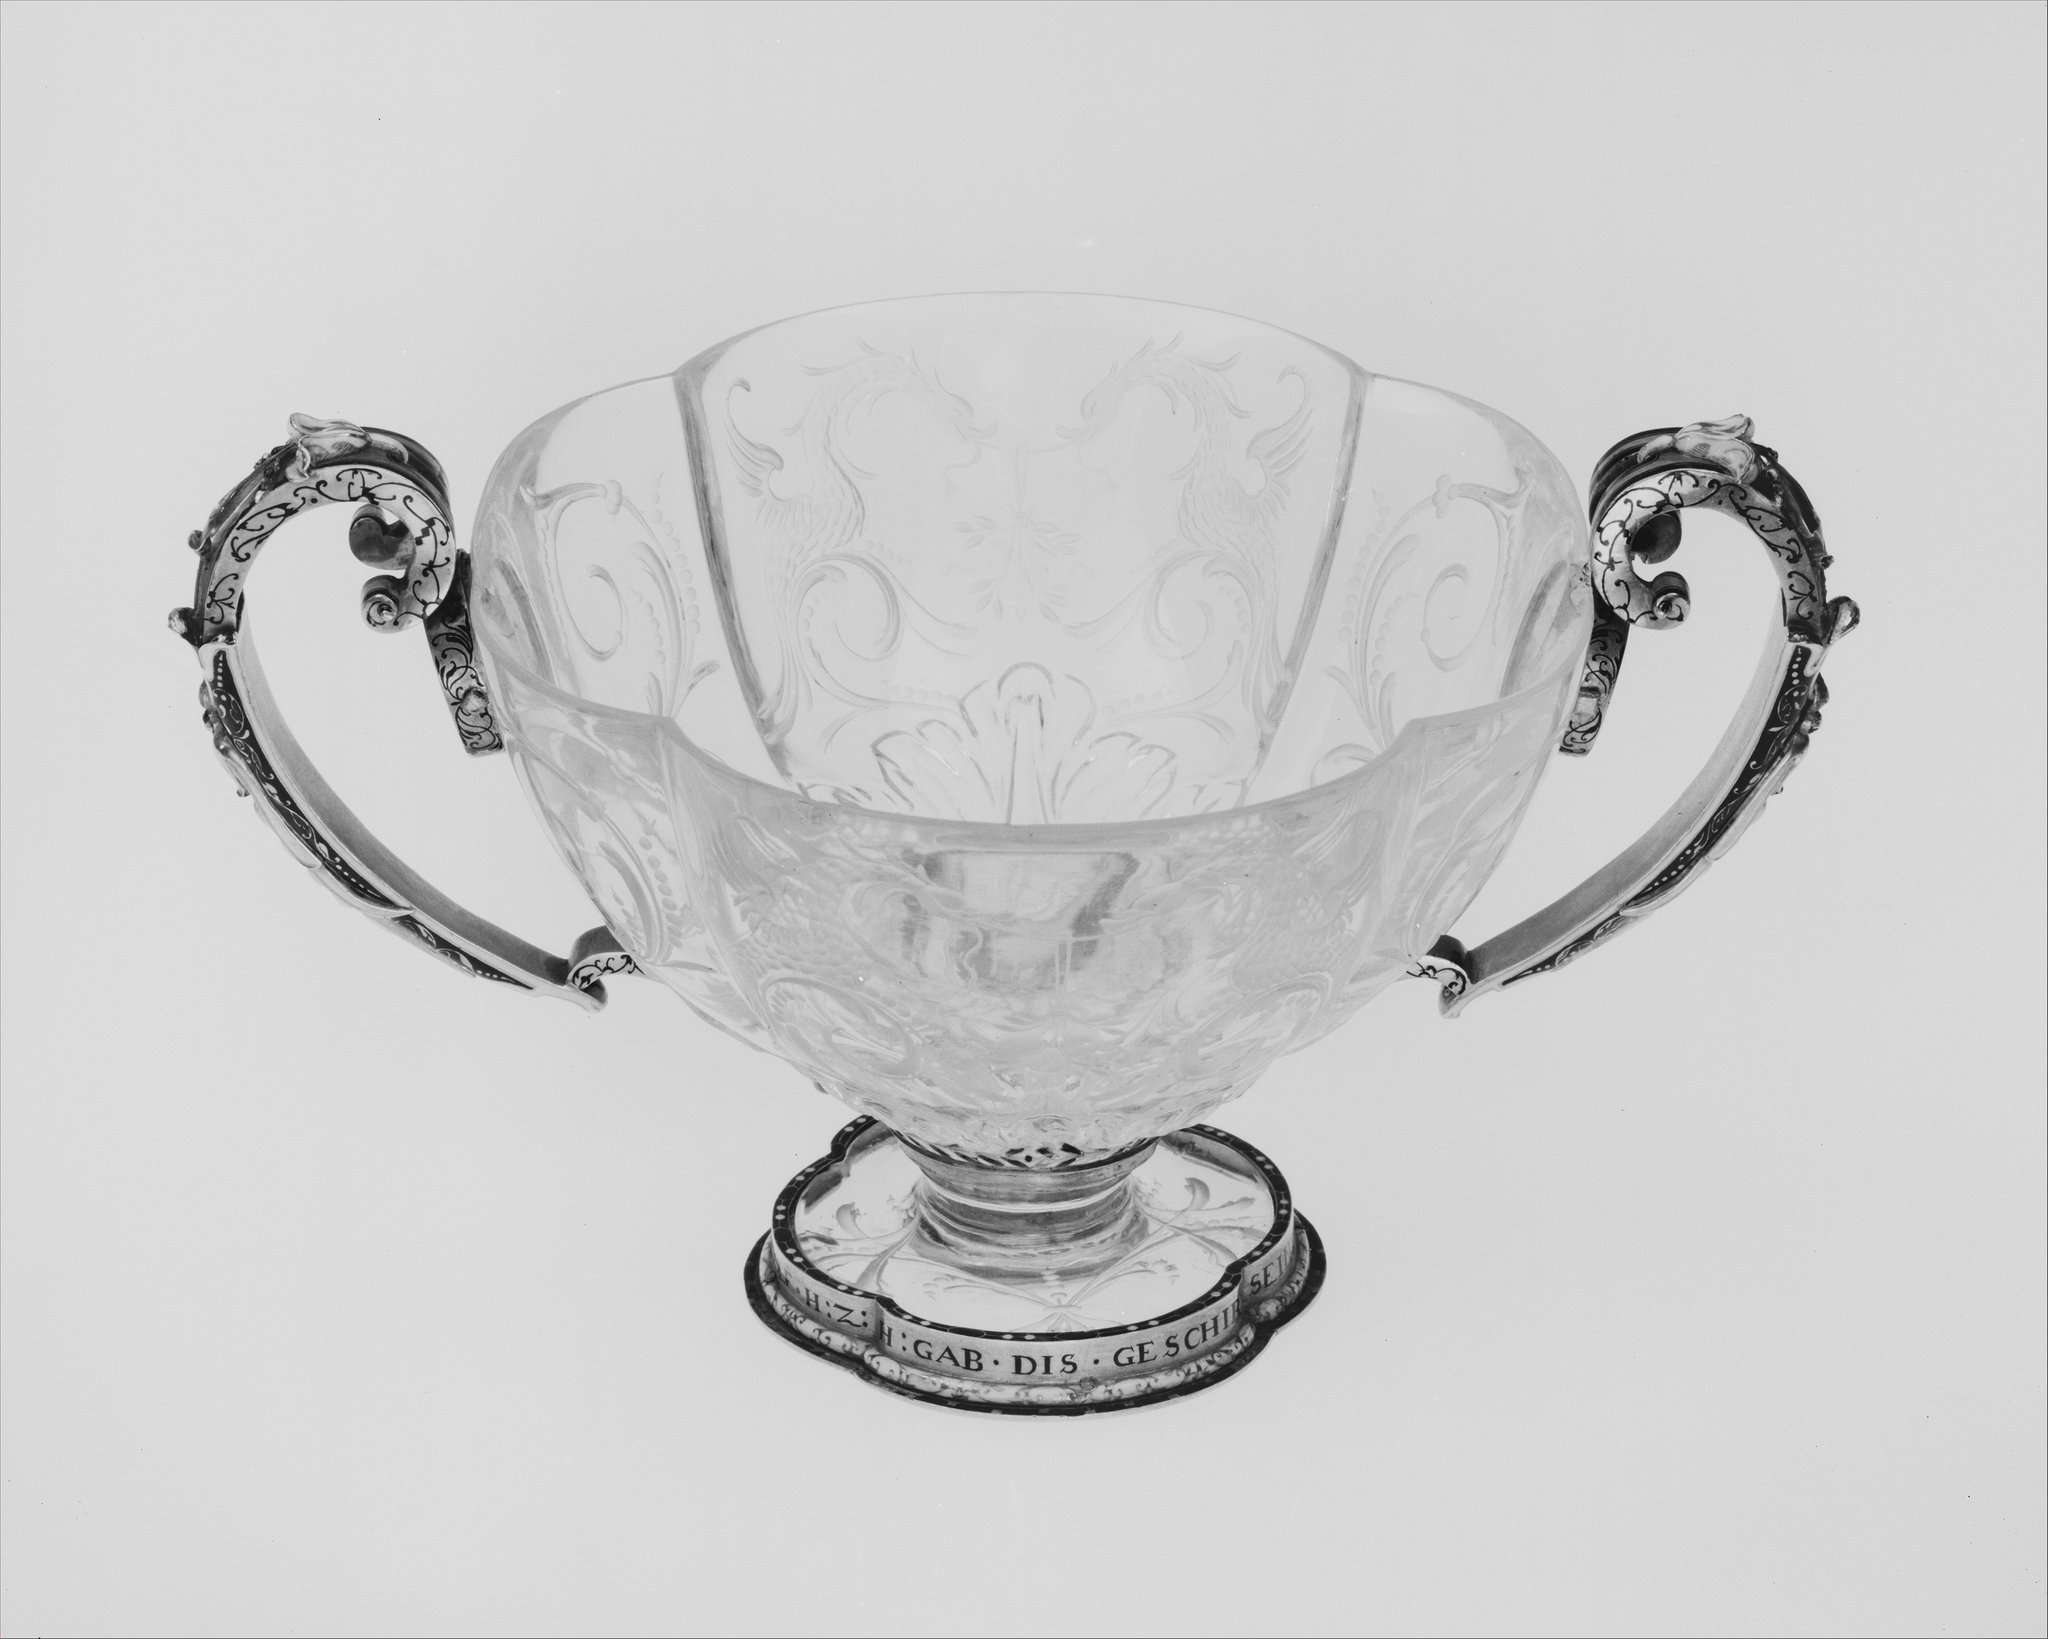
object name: cup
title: Two-handled cup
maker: dionysio miseroni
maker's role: maker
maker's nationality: bohemian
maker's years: 1607-1661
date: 1634-1666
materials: gold, quartz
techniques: enamel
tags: animals